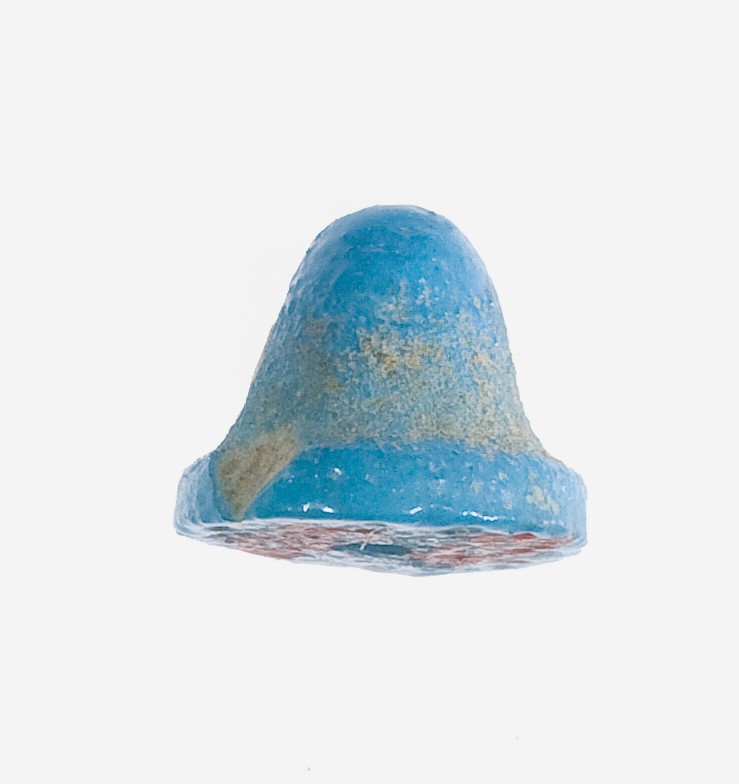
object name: pendant, umbel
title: Umbel Pendant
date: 1390-1352 BCE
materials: faience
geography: egypt